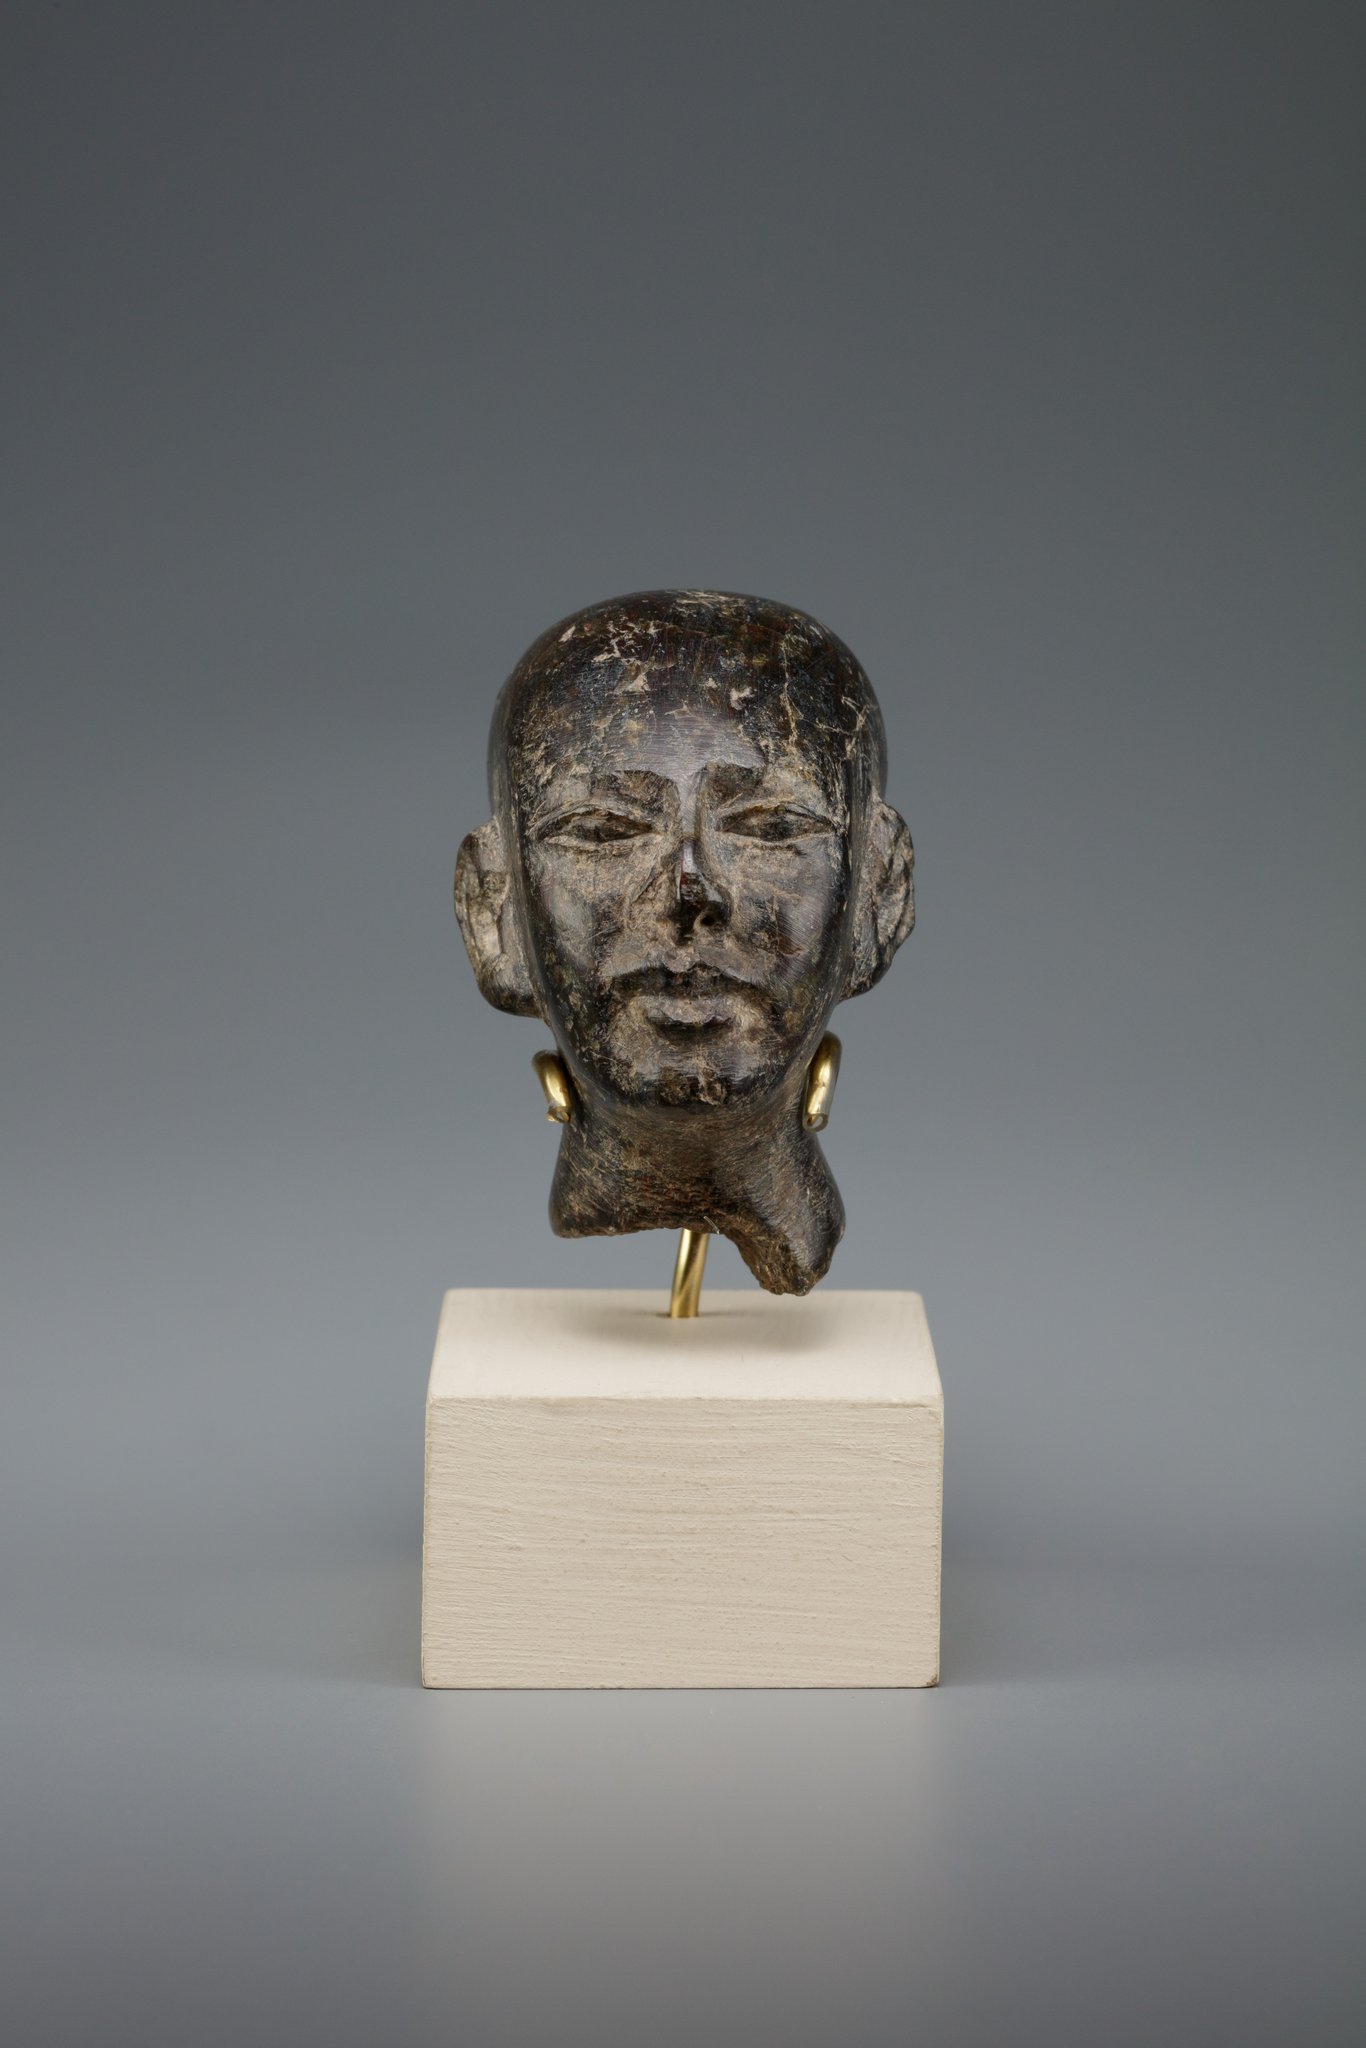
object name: head, male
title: Head of male statue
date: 1802-1640 BCE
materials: stone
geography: egypt